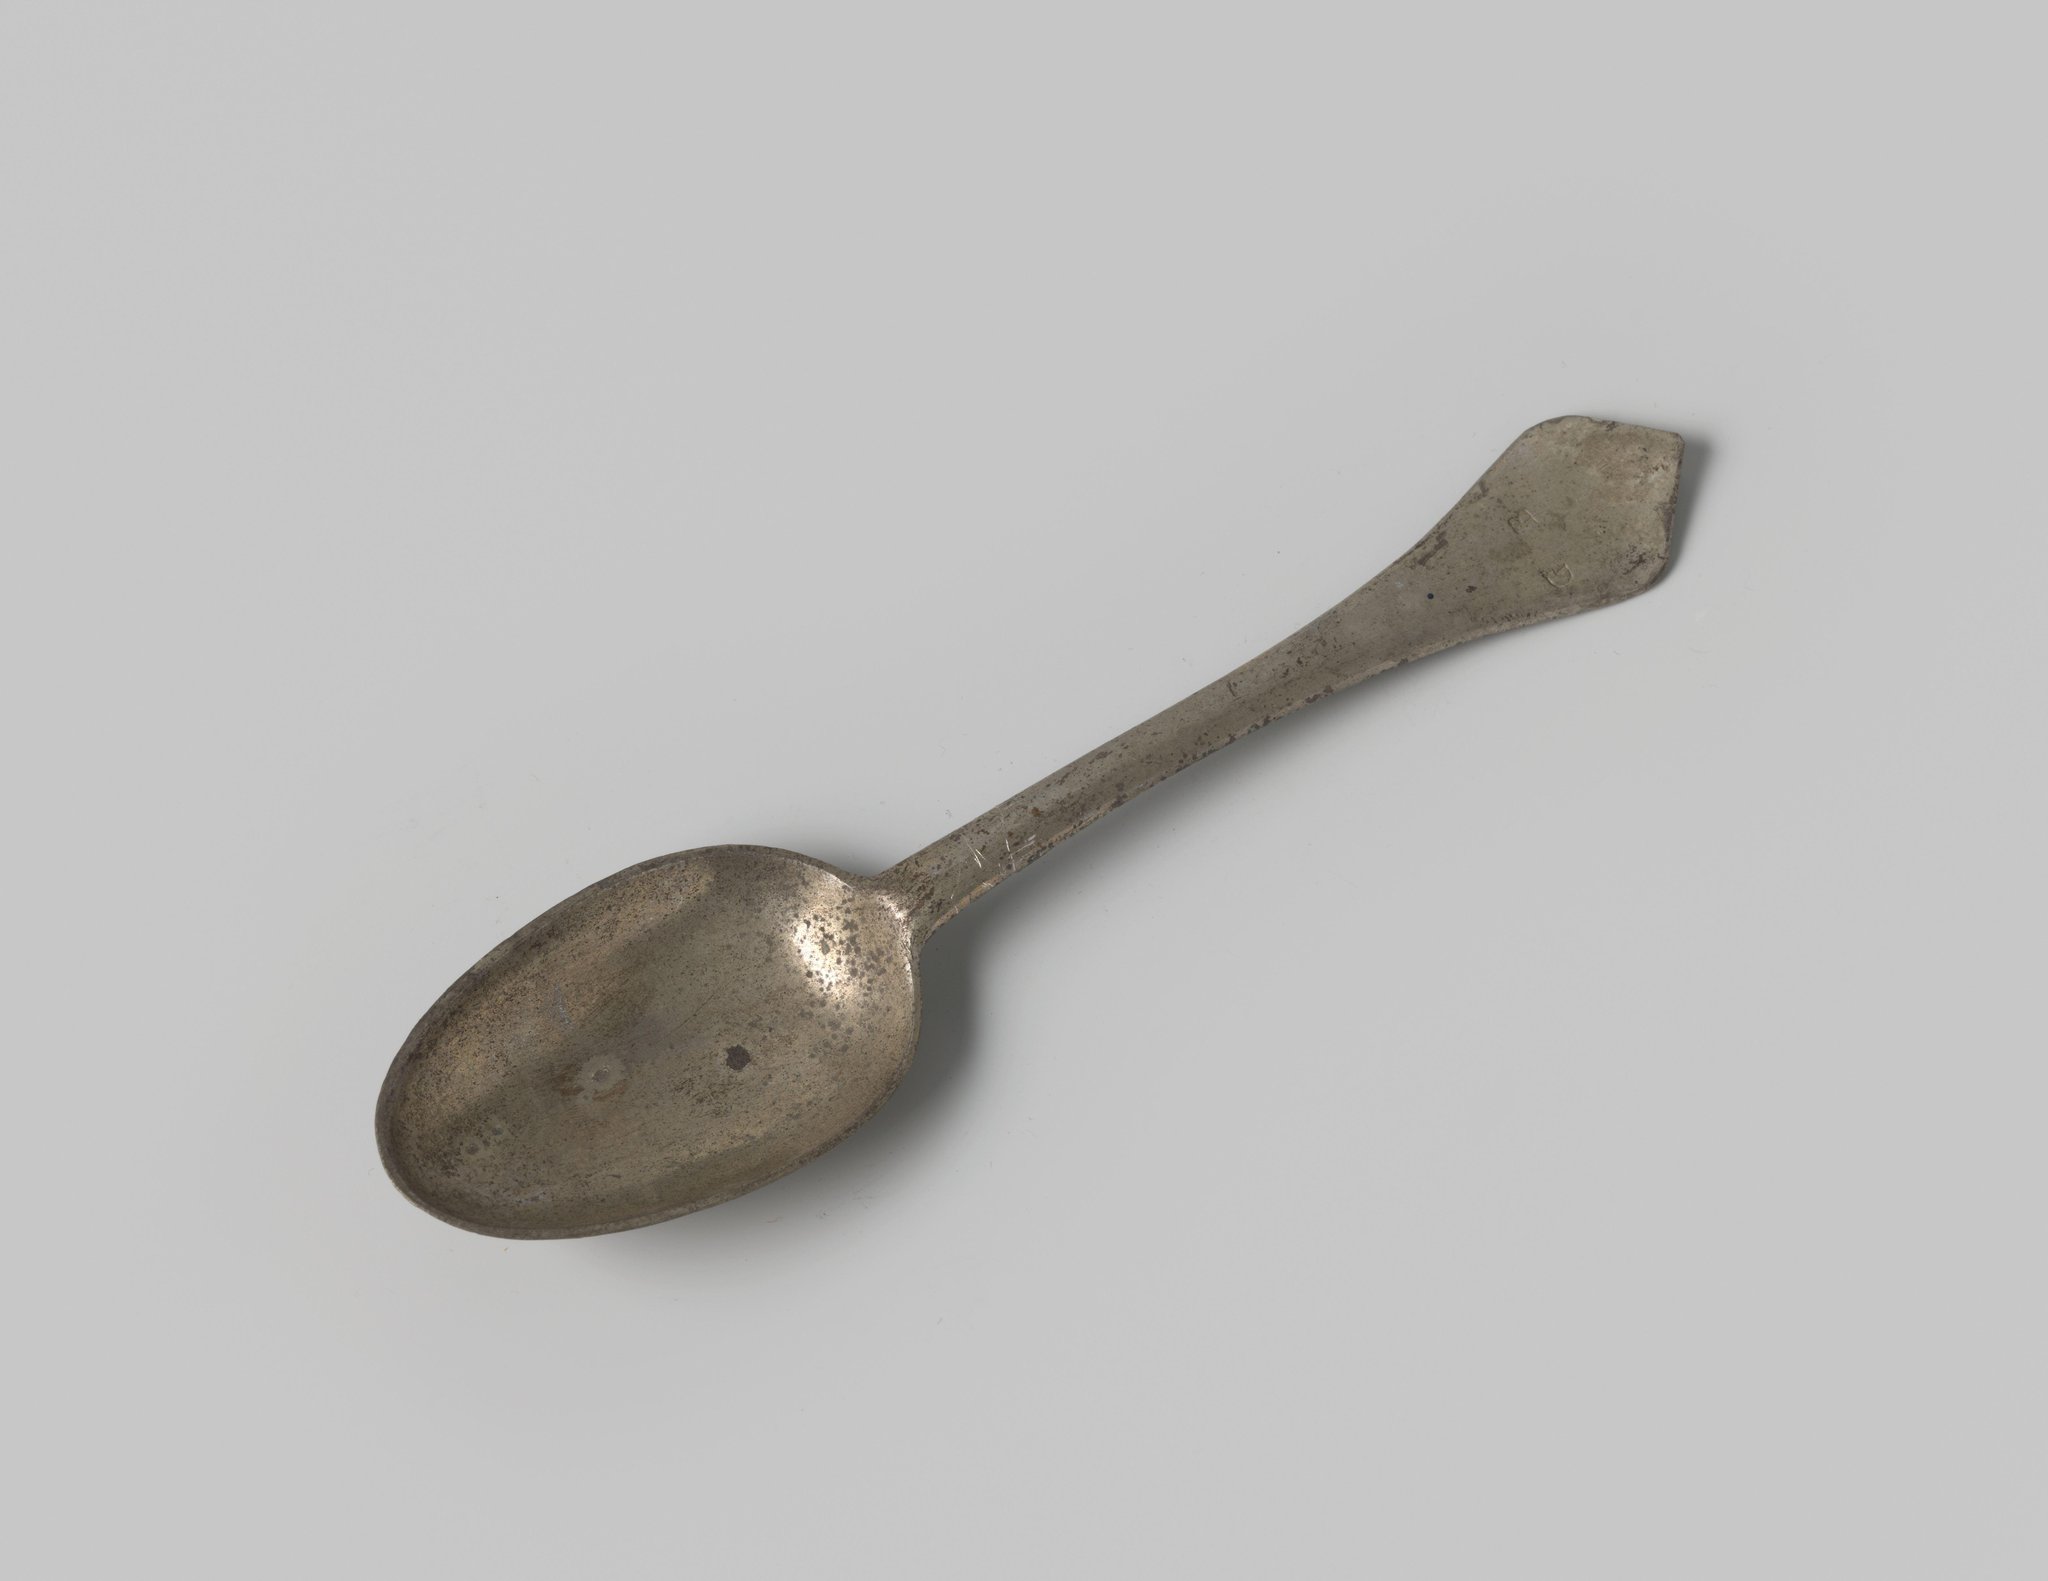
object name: spoon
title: Lepel uit het wrak van de Oost-Indiëvaarder 't Vliegend Hart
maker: paulus verbrugge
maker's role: pewterers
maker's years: 1639-1693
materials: tin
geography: middelburg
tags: 't vliegend hart (schip), verenigde oostindische compagnie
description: Tinnen lepel, met ovale bak en een steel met akkoladevormig steeleinde. De steel loopt op de achterzijde van de bak door met een lange naald en lofje. Met gekroond wapenschild en letters LOCKTIN EN BRVGGE en op steel GB SVE